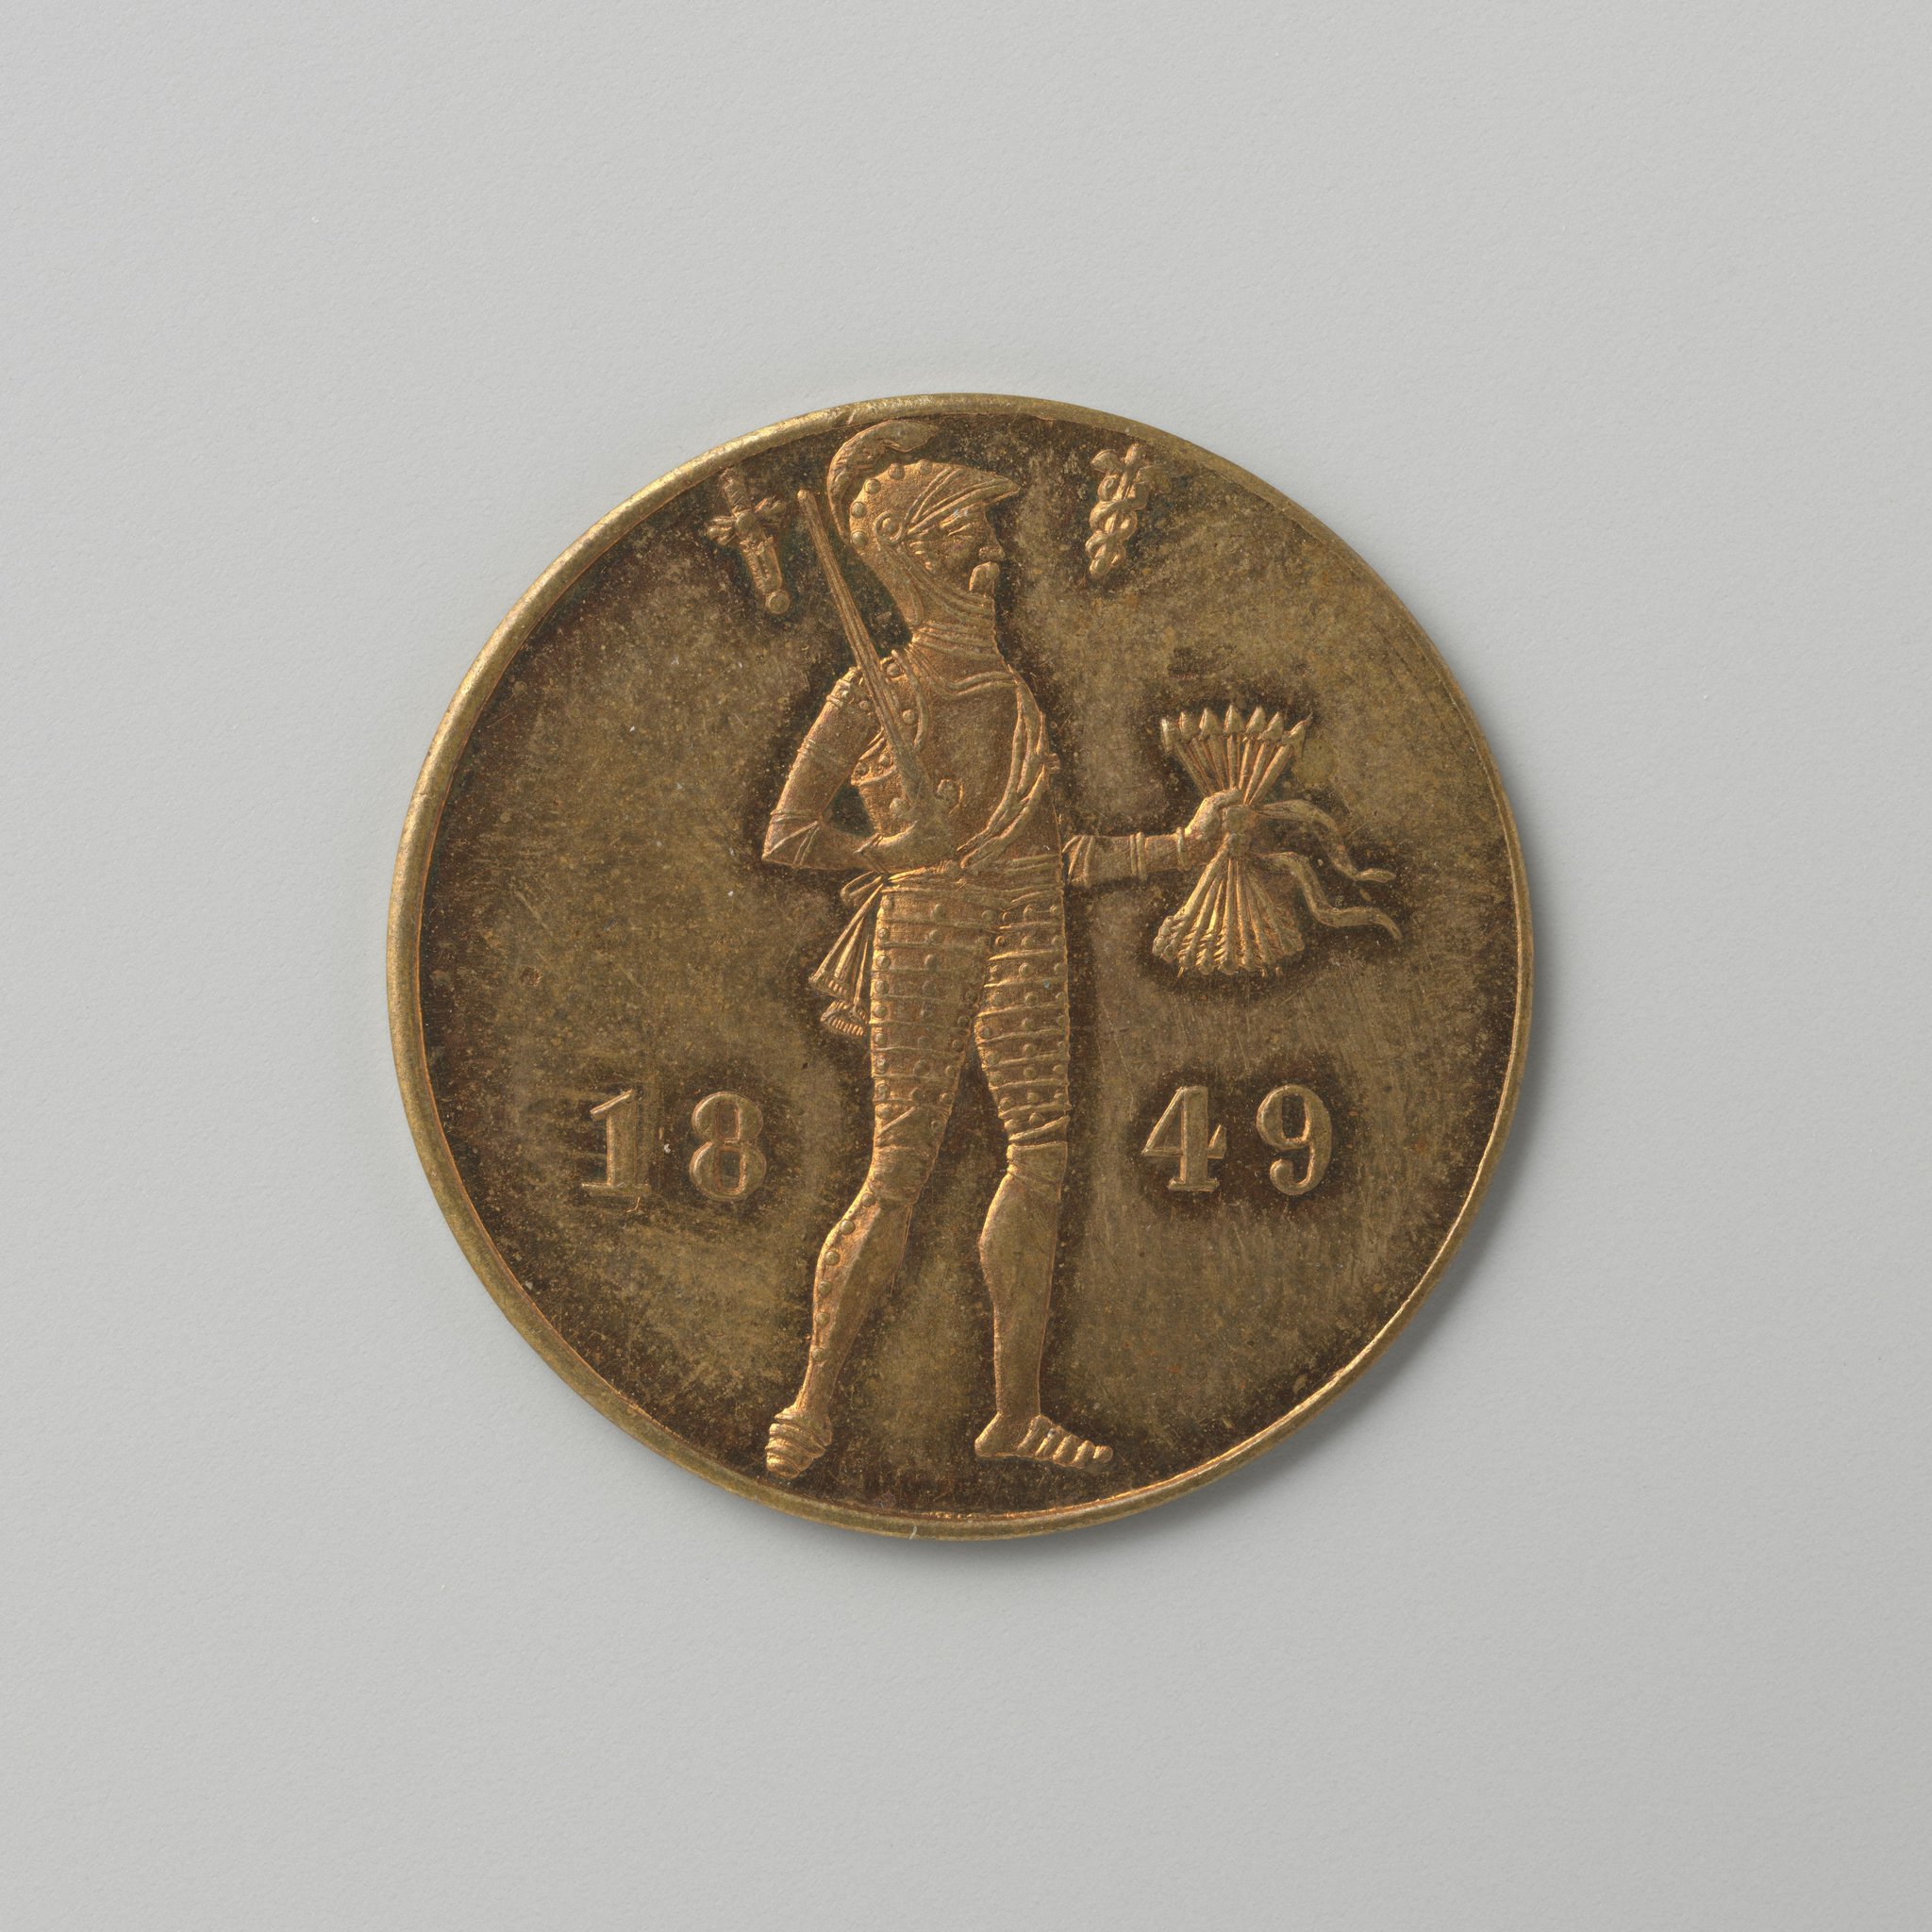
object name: gouden dukaat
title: Proefslag voor een gouden dukaat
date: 1849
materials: copper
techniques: striking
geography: utrecht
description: Afslag van een gouden dukaat - zonder omschrift op de voorzijde - op een koperen plaatje